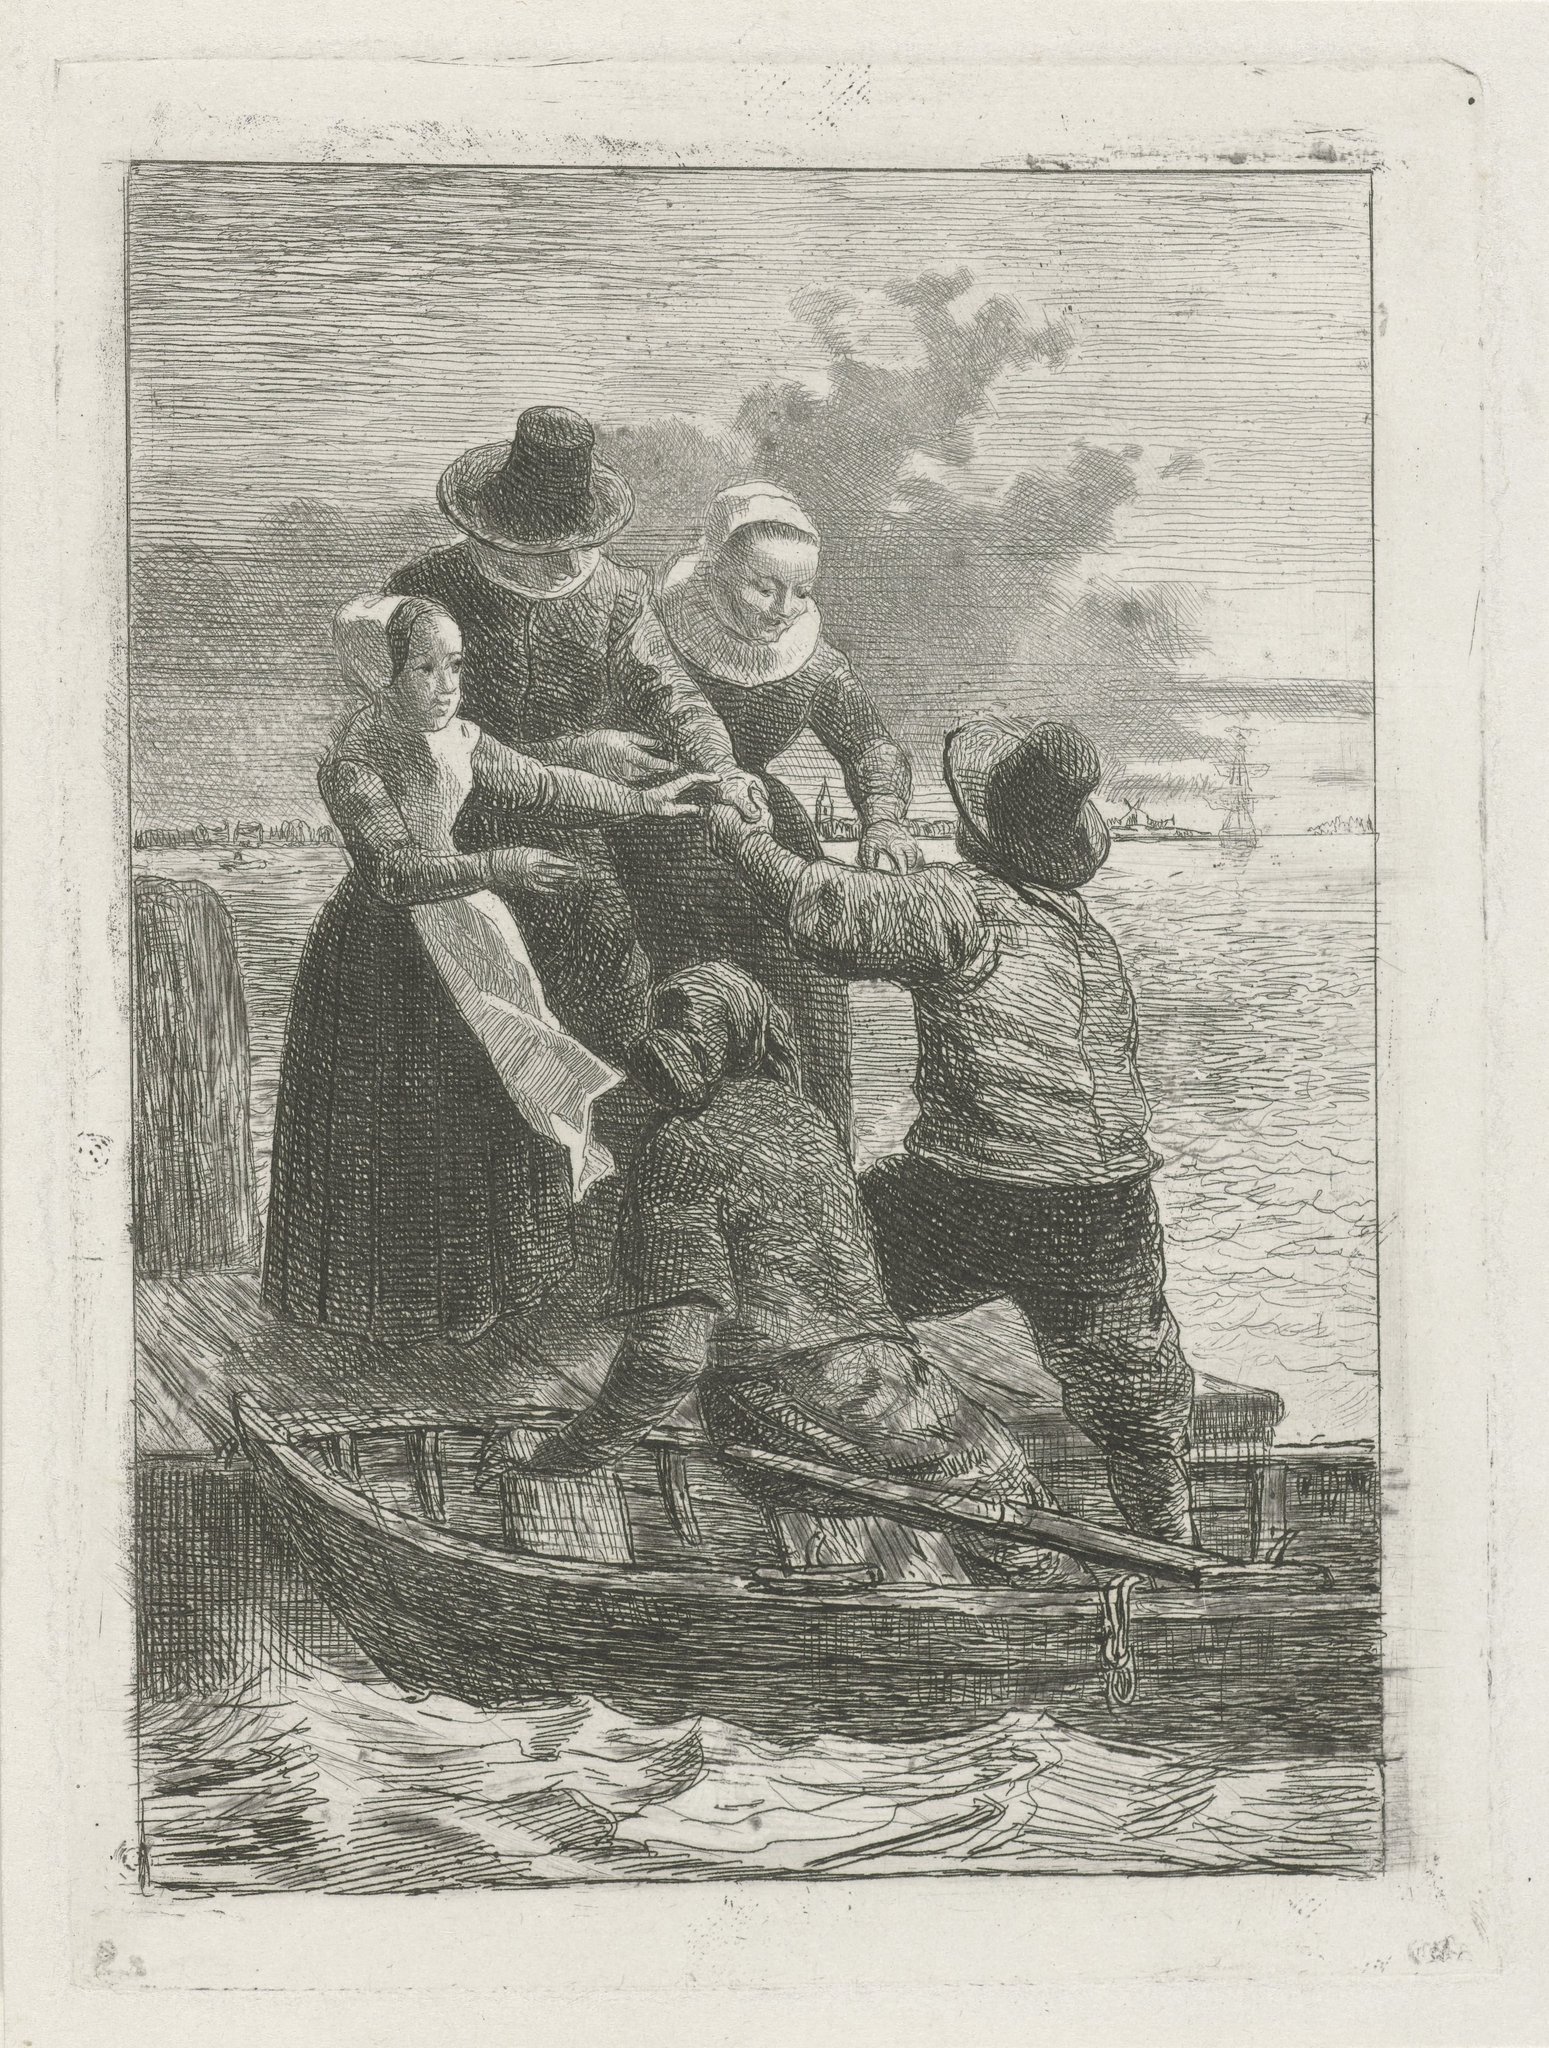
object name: print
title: Inscheping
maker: reinier craeyvanger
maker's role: draughtsman, print maker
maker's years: 1812-1880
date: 1822-1880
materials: paper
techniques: etching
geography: amsterdam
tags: family group, especially parents with their child(ren), rowing-boat, canoe, etc., seaman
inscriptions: collector's mark: Lugt 2228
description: Een schipper helpt een gezin van een vader, een moeder en een dochter met inschepen op de roeiboot.